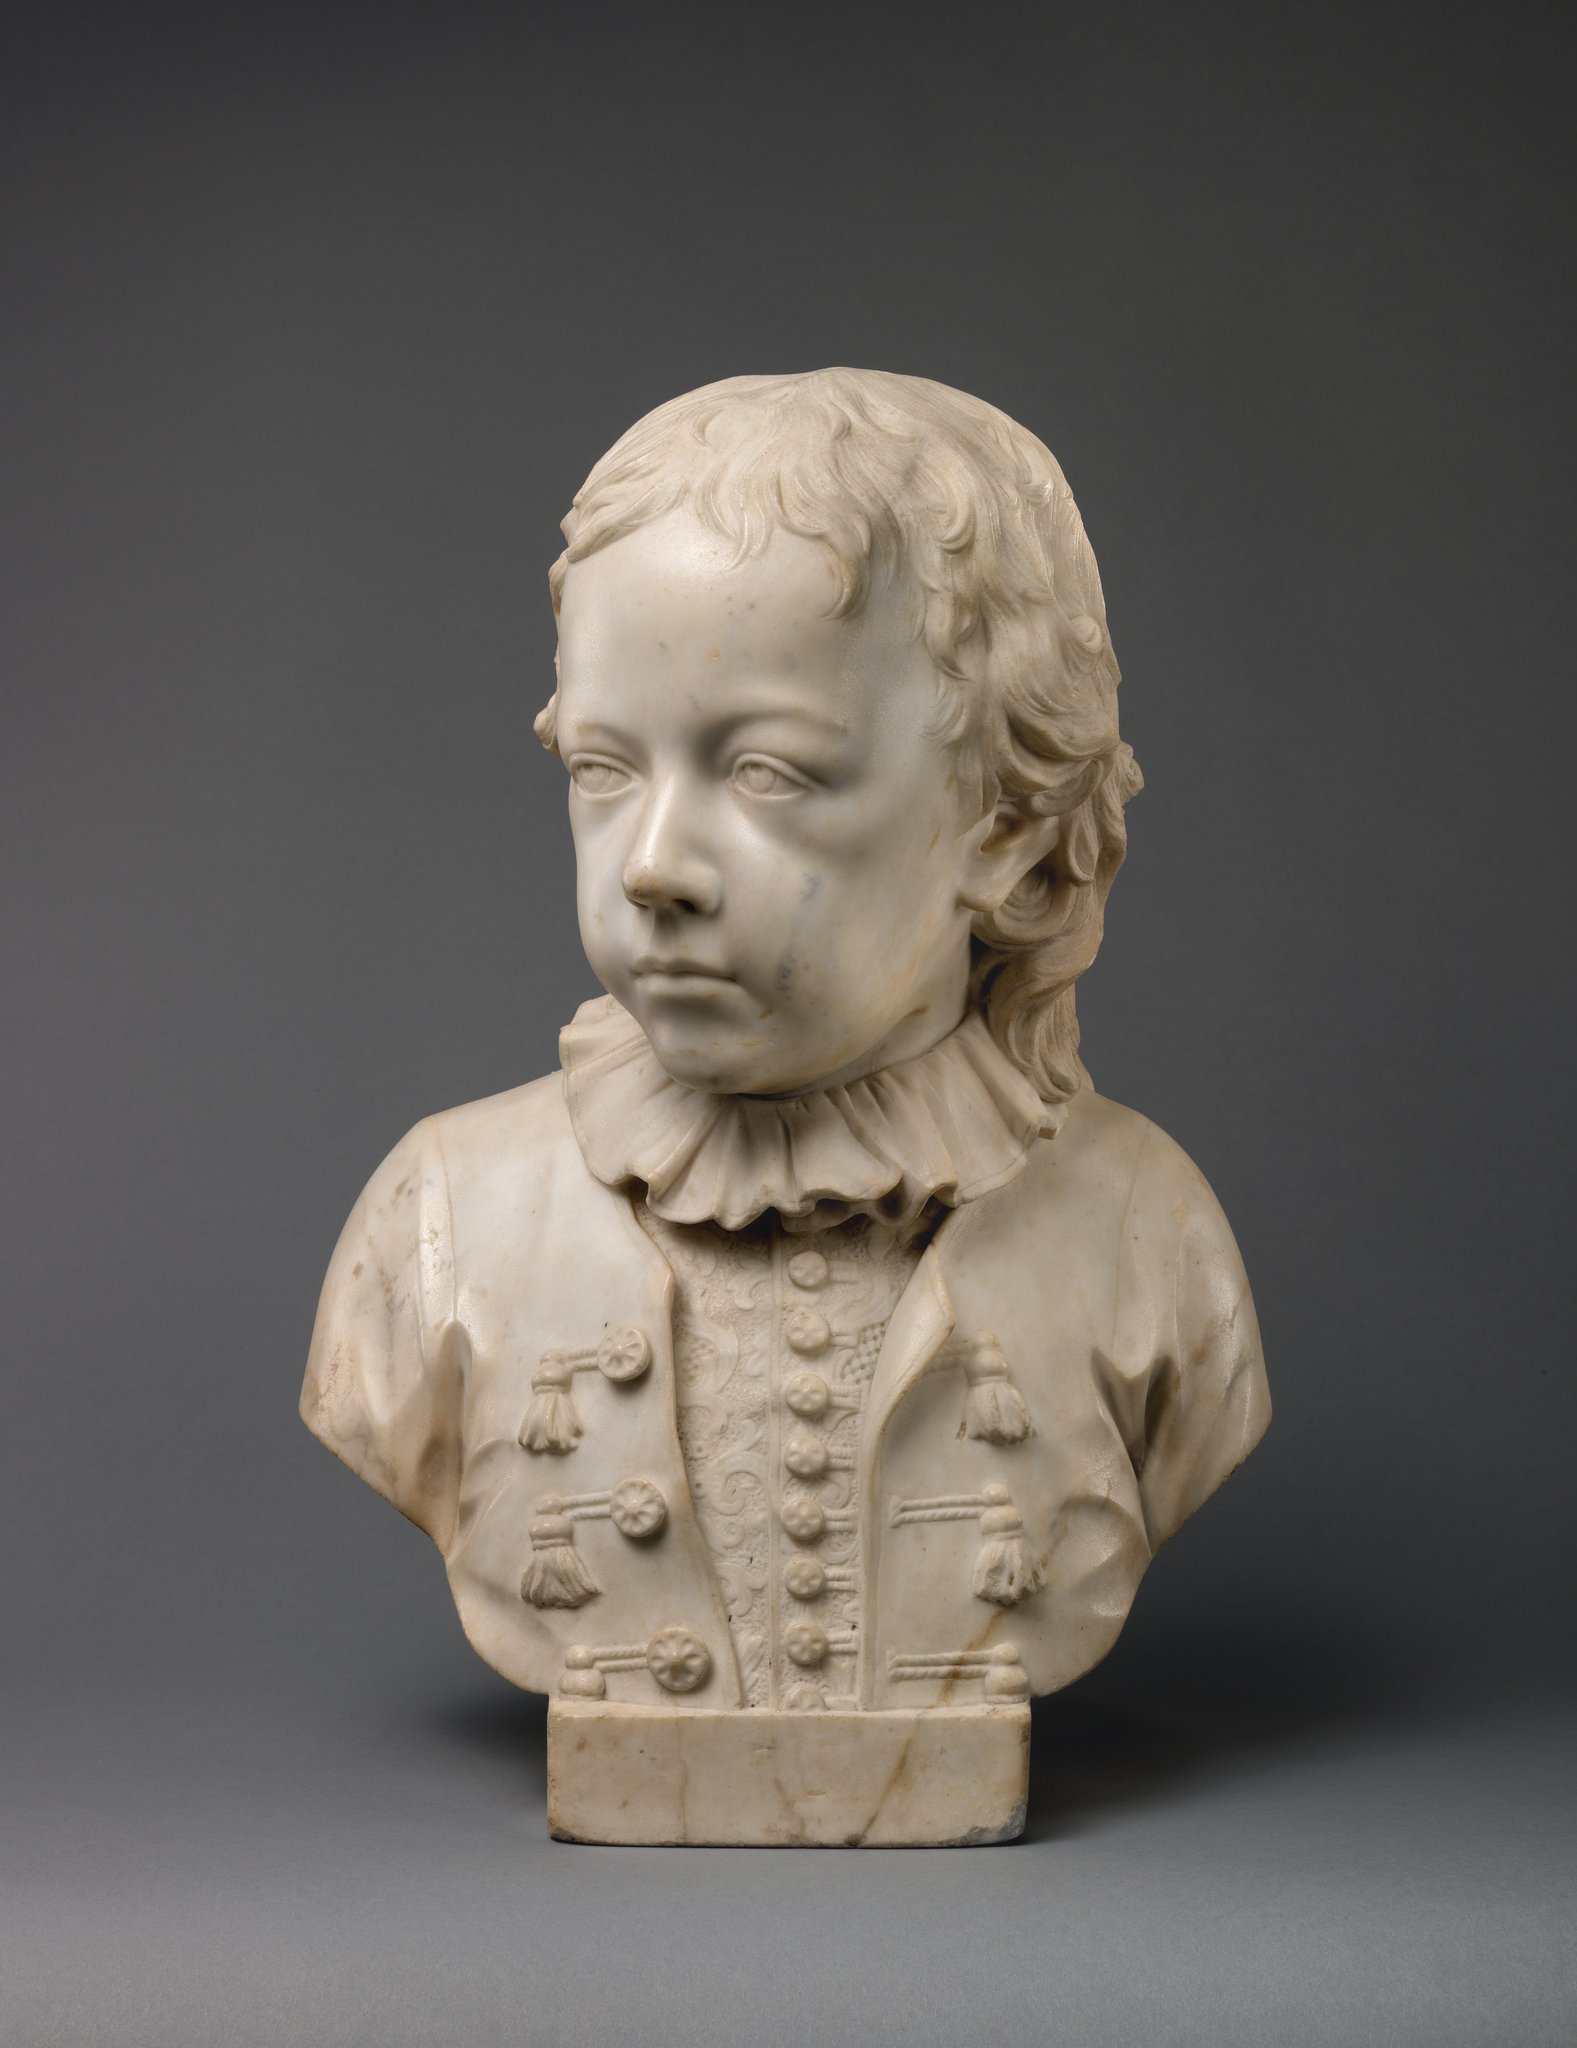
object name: bust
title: John Barnard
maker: john michael rysbrack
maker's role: artist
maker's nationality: flemish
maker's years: 1694-1770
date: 1744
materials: marble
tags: boys,portraits